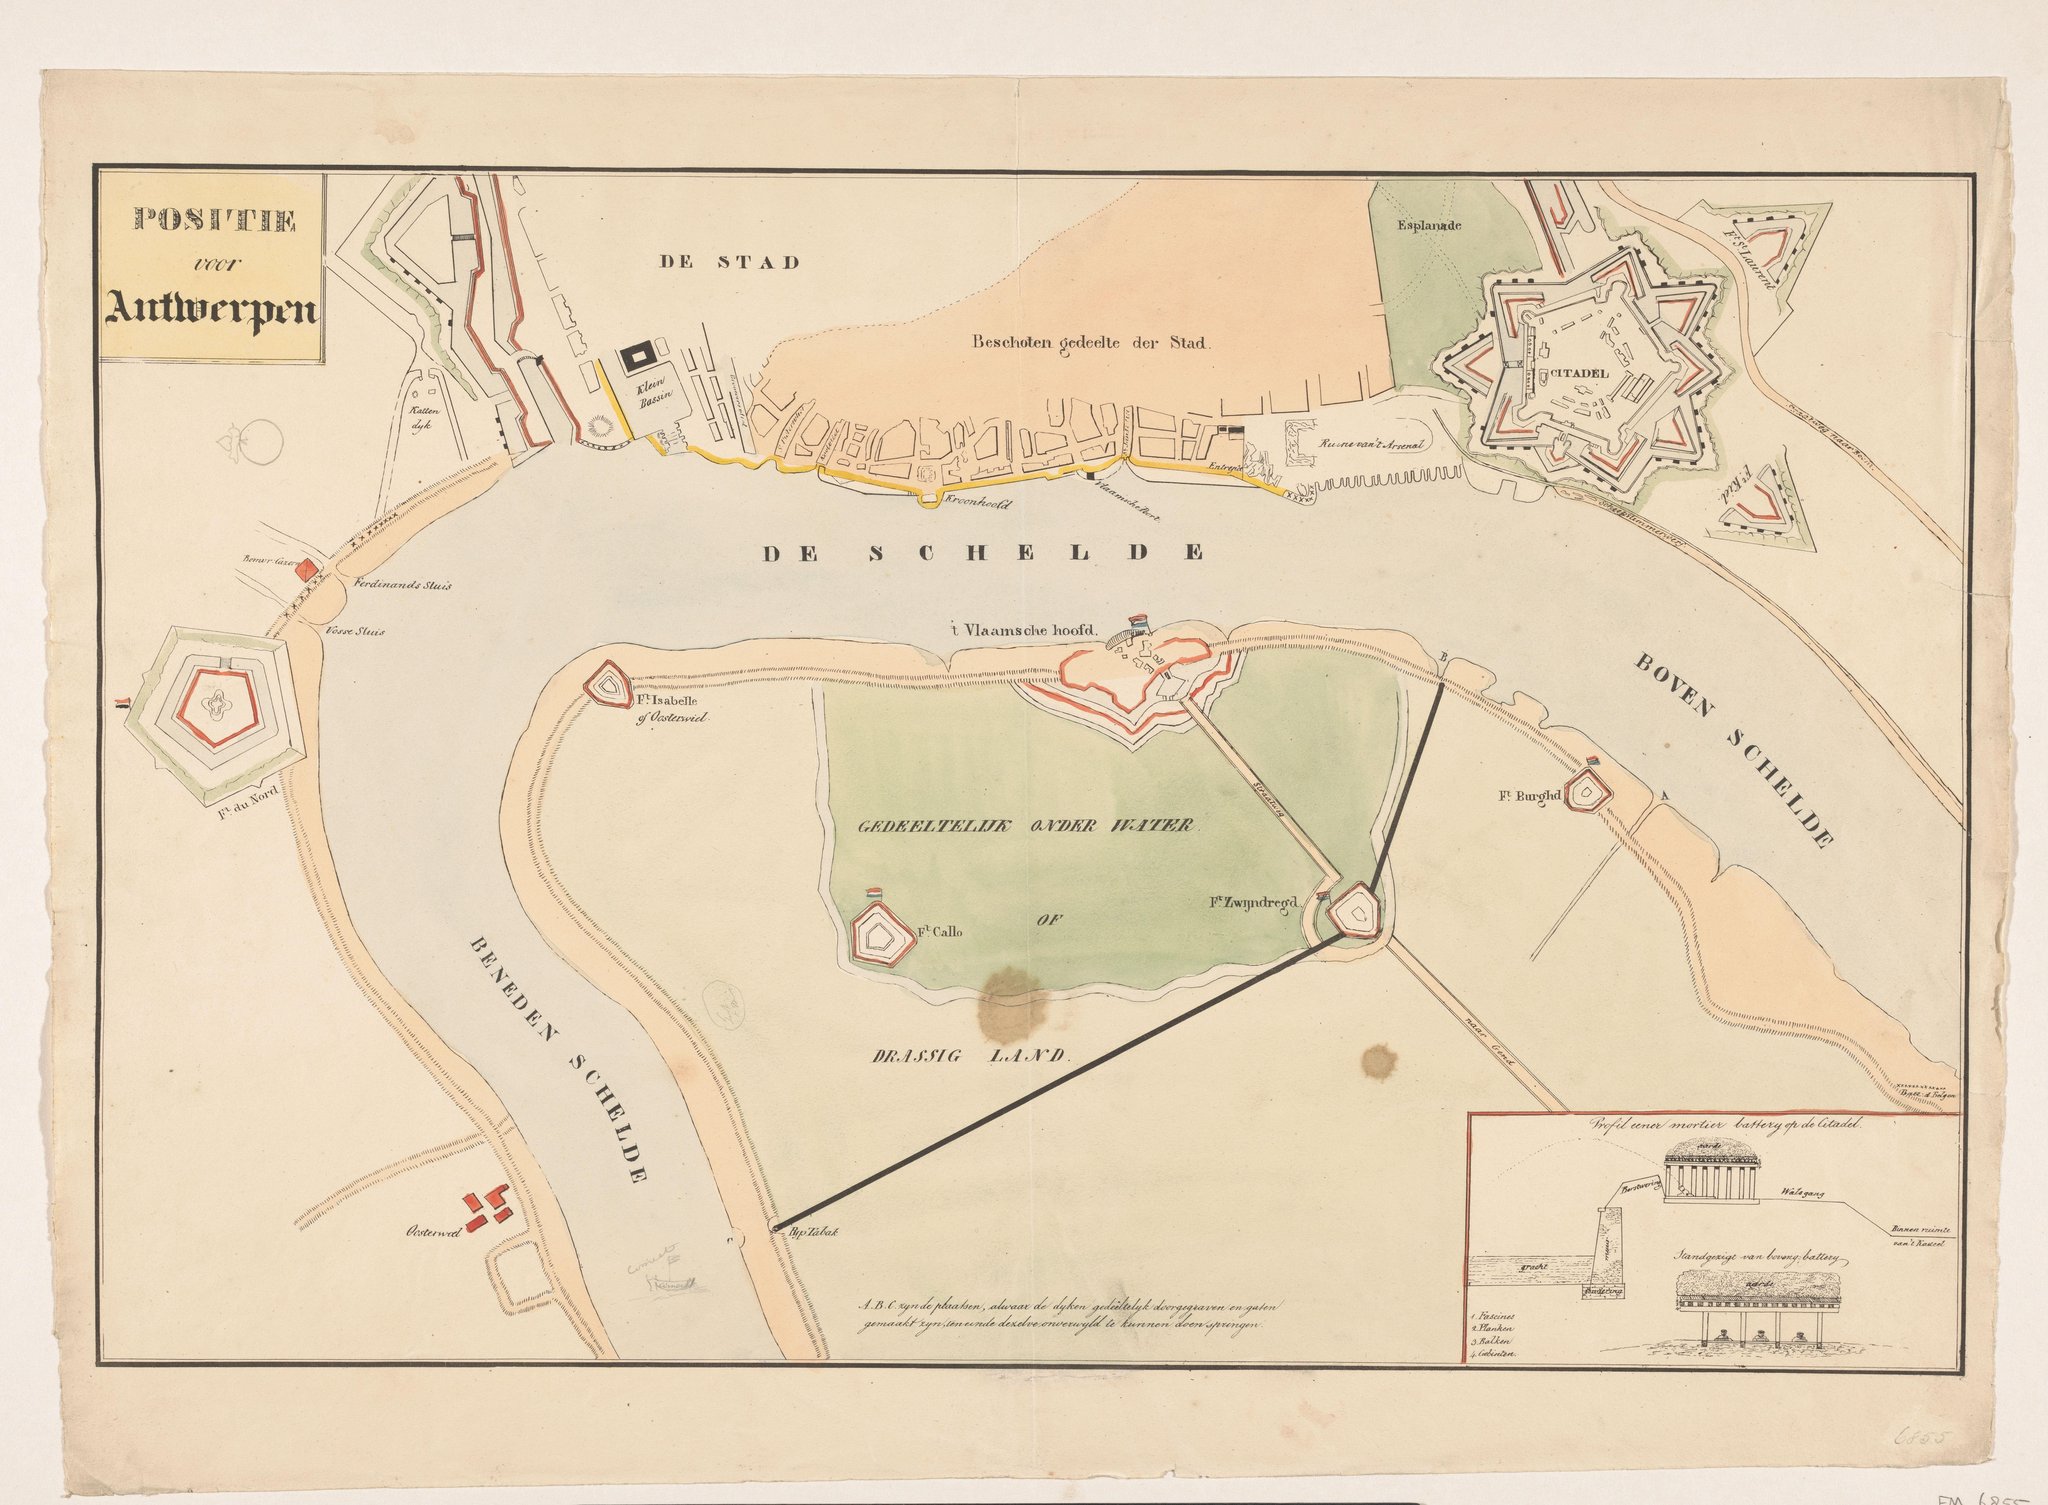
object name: print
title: Plan van de Schelde voor Antwerpen met de ligging van de forten, tijdens het beleg van de Citadel, 1832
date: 1832-1833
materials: paper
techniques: hand coloring, lithograph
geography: netherlands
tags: permanent fortifications, antwerp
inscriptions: collector's mark: Lugt 2228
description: Plan van de Schelde voor Antwerpen, met de Citadel en de andere forten in Nederlandse handen, tijdens het beleg van de Citadel door de Fransen. Zonder de Nederlandse kanonneerboten op de Schelde. Rechtsonder een inzet met twee afbeeldingen van een batterij op de Citadel.